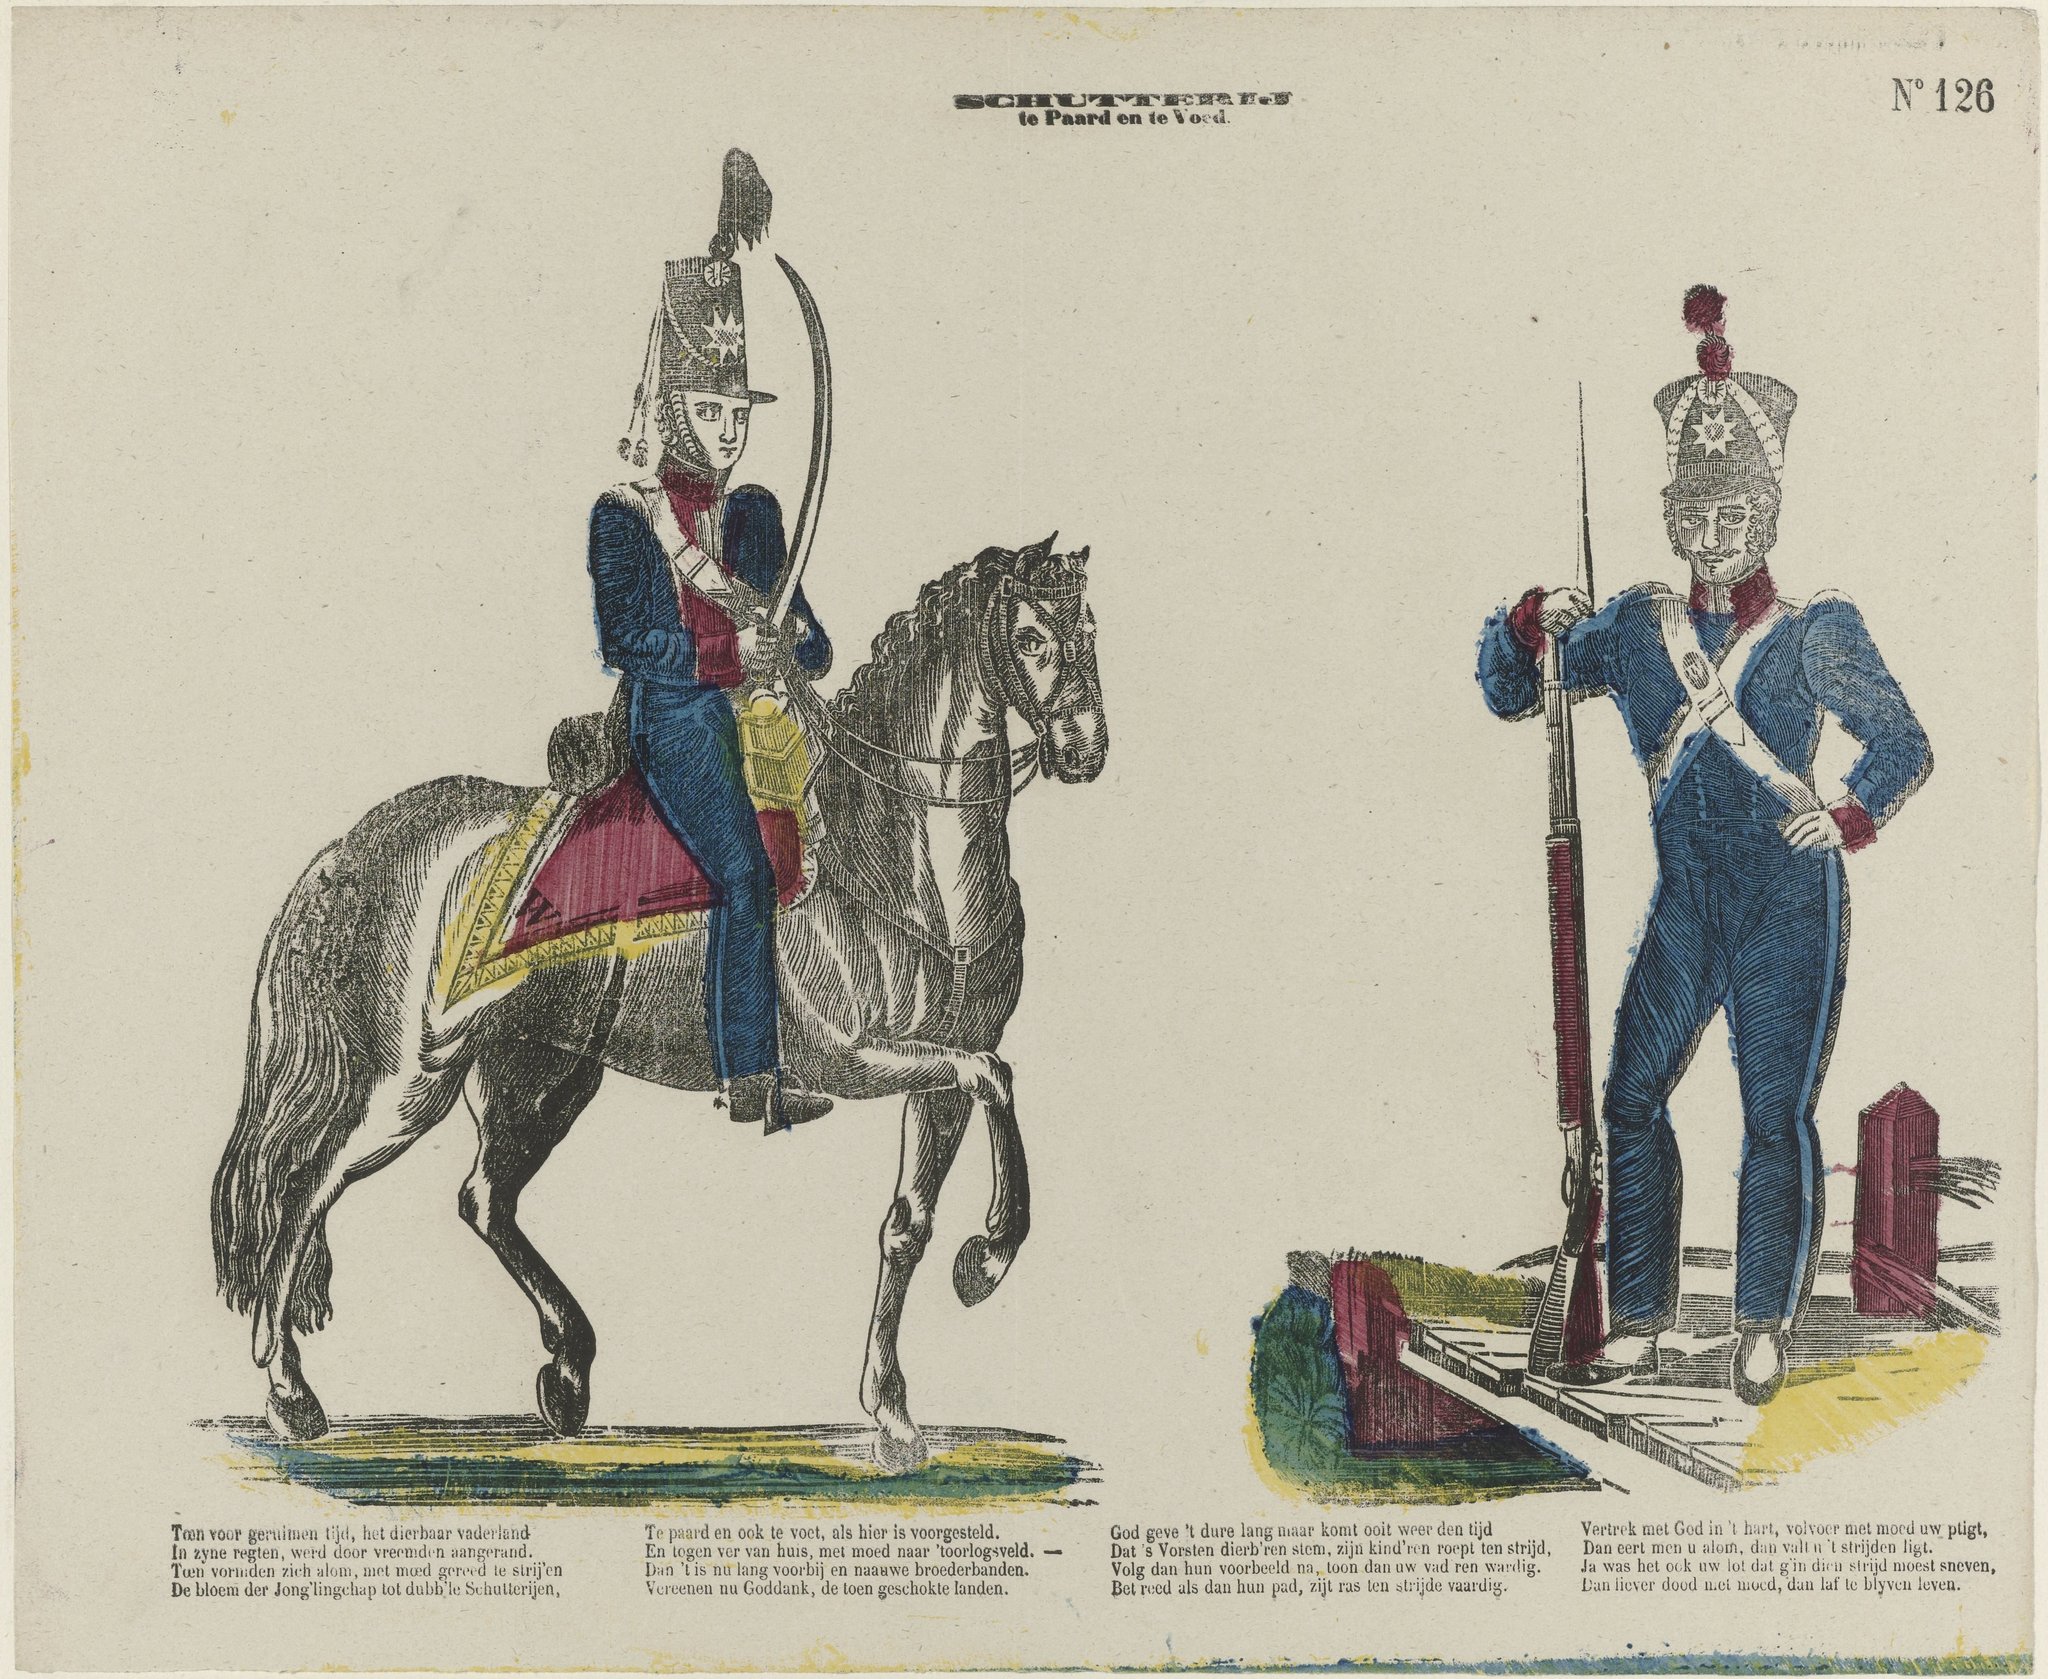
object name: popular print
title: Schutterij / te paard en te voet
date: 1827-1894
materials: paper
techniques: colour, letterpress printing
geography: schaarbeek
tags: warfare; military affairs (+ cavalry, horsemen), the soldier; the soldier's life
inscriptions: collector's mark: Lugt 2760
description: Blad met 2 voorstellingen van militairen. Onder elke afbeelding een achtregelig vers in twee kolommen. Genummerd rechtsboven: No 126.